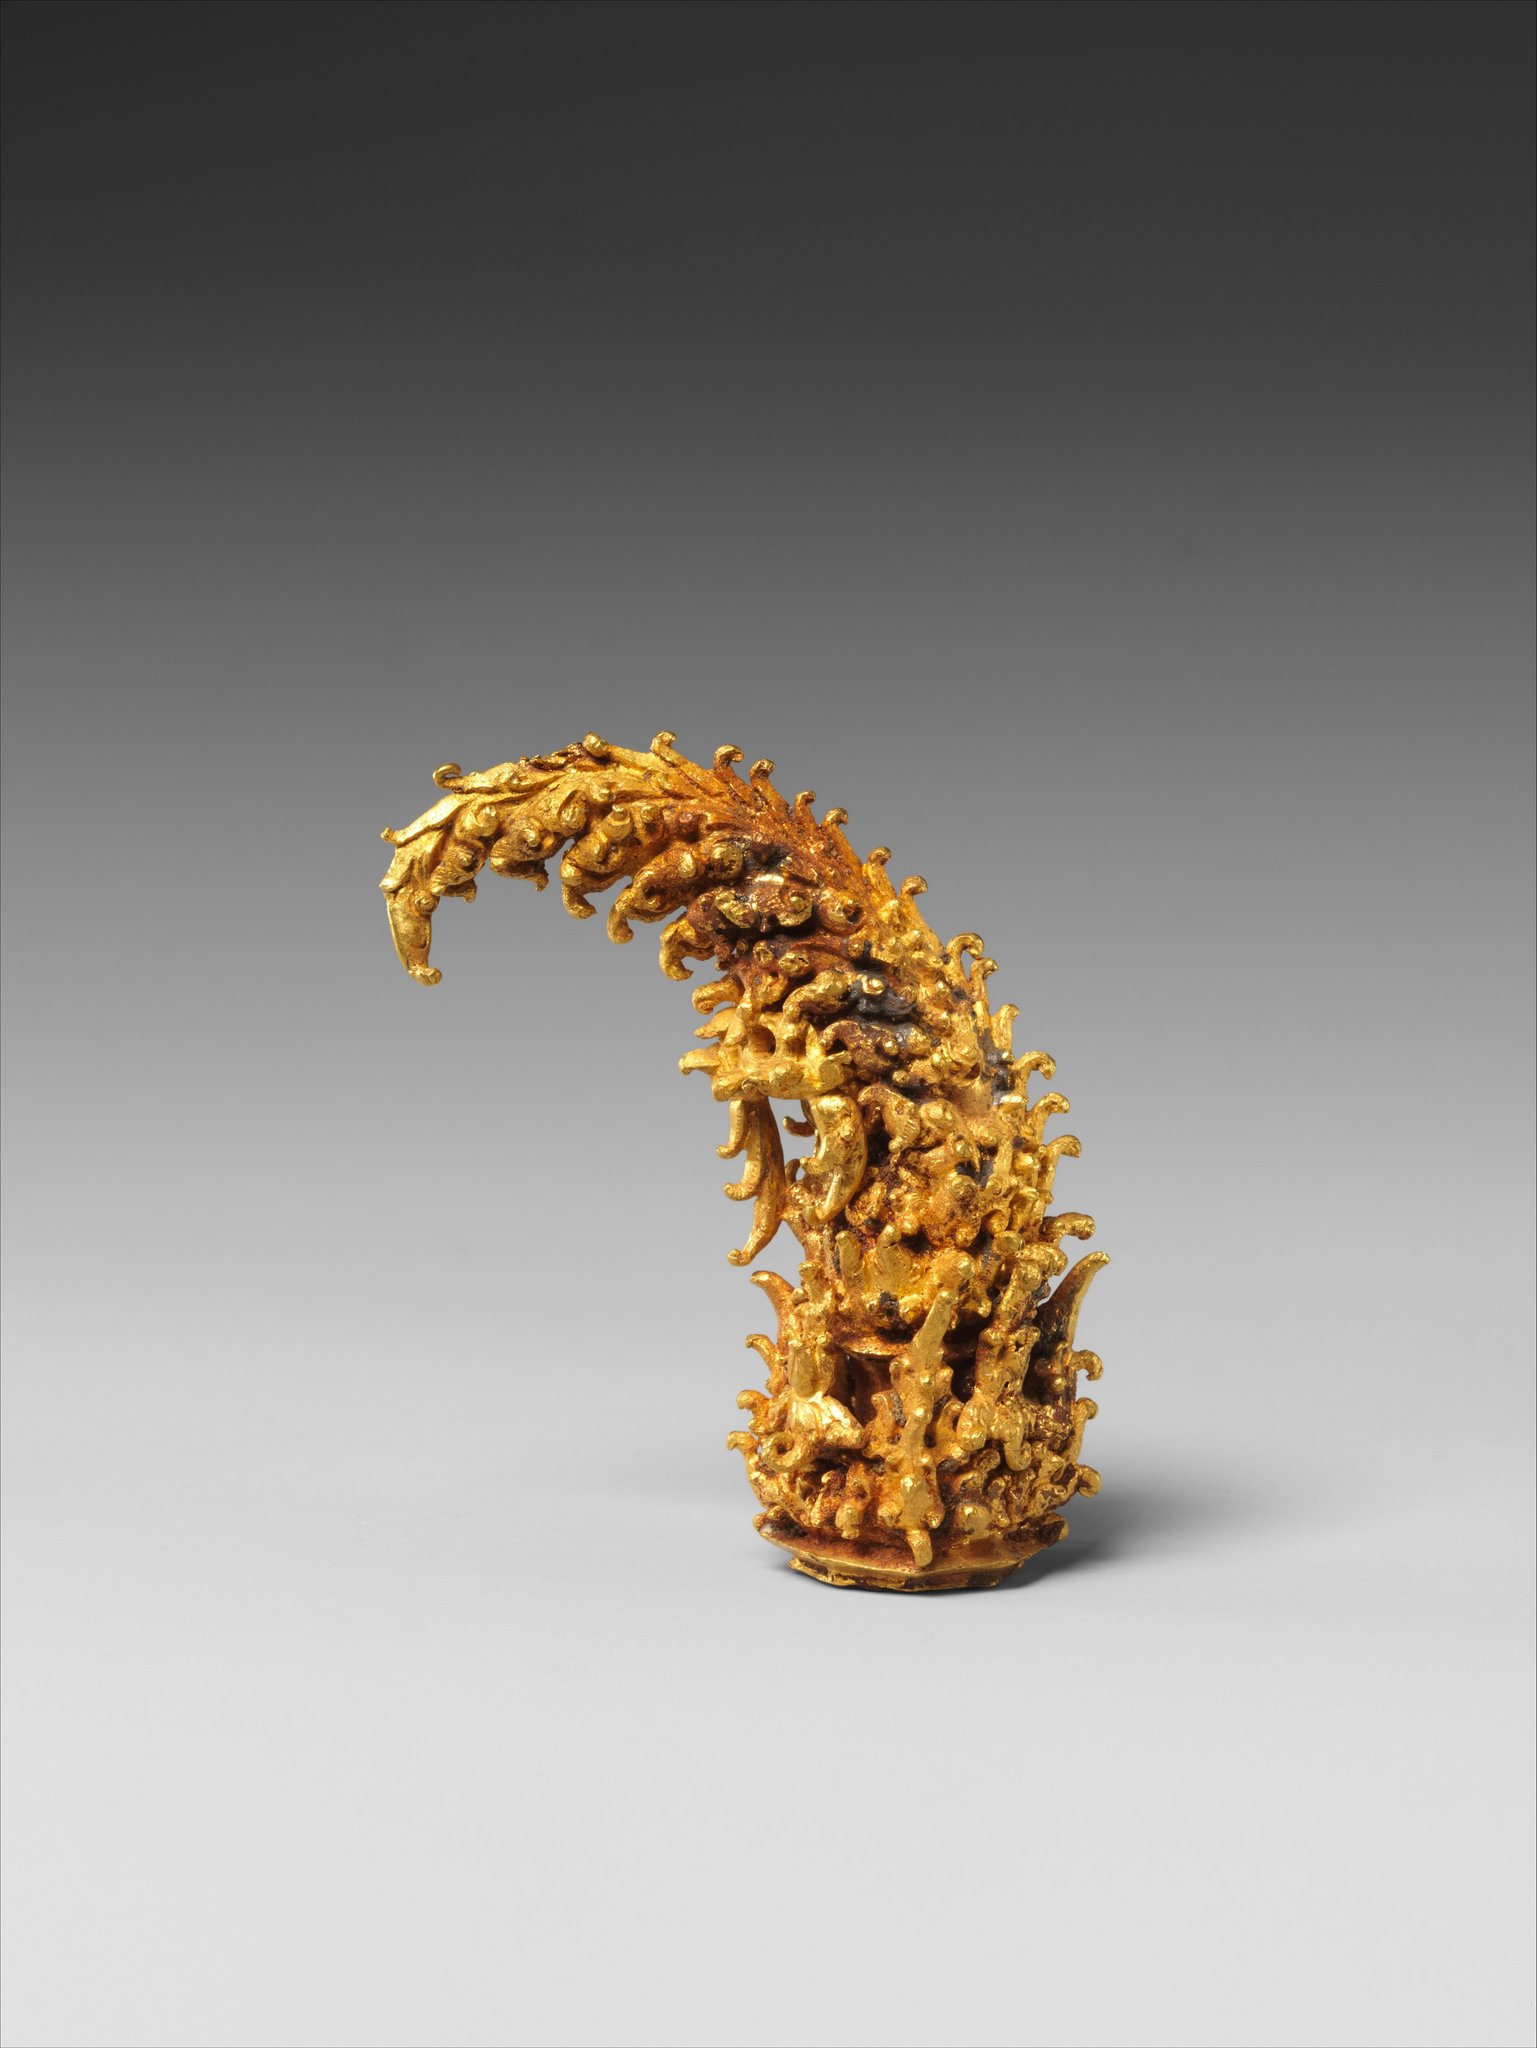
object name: weapon handle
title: Weapon Handle with Ganesha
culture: indonesian, javanese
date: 801-1400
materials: gold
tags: hilts